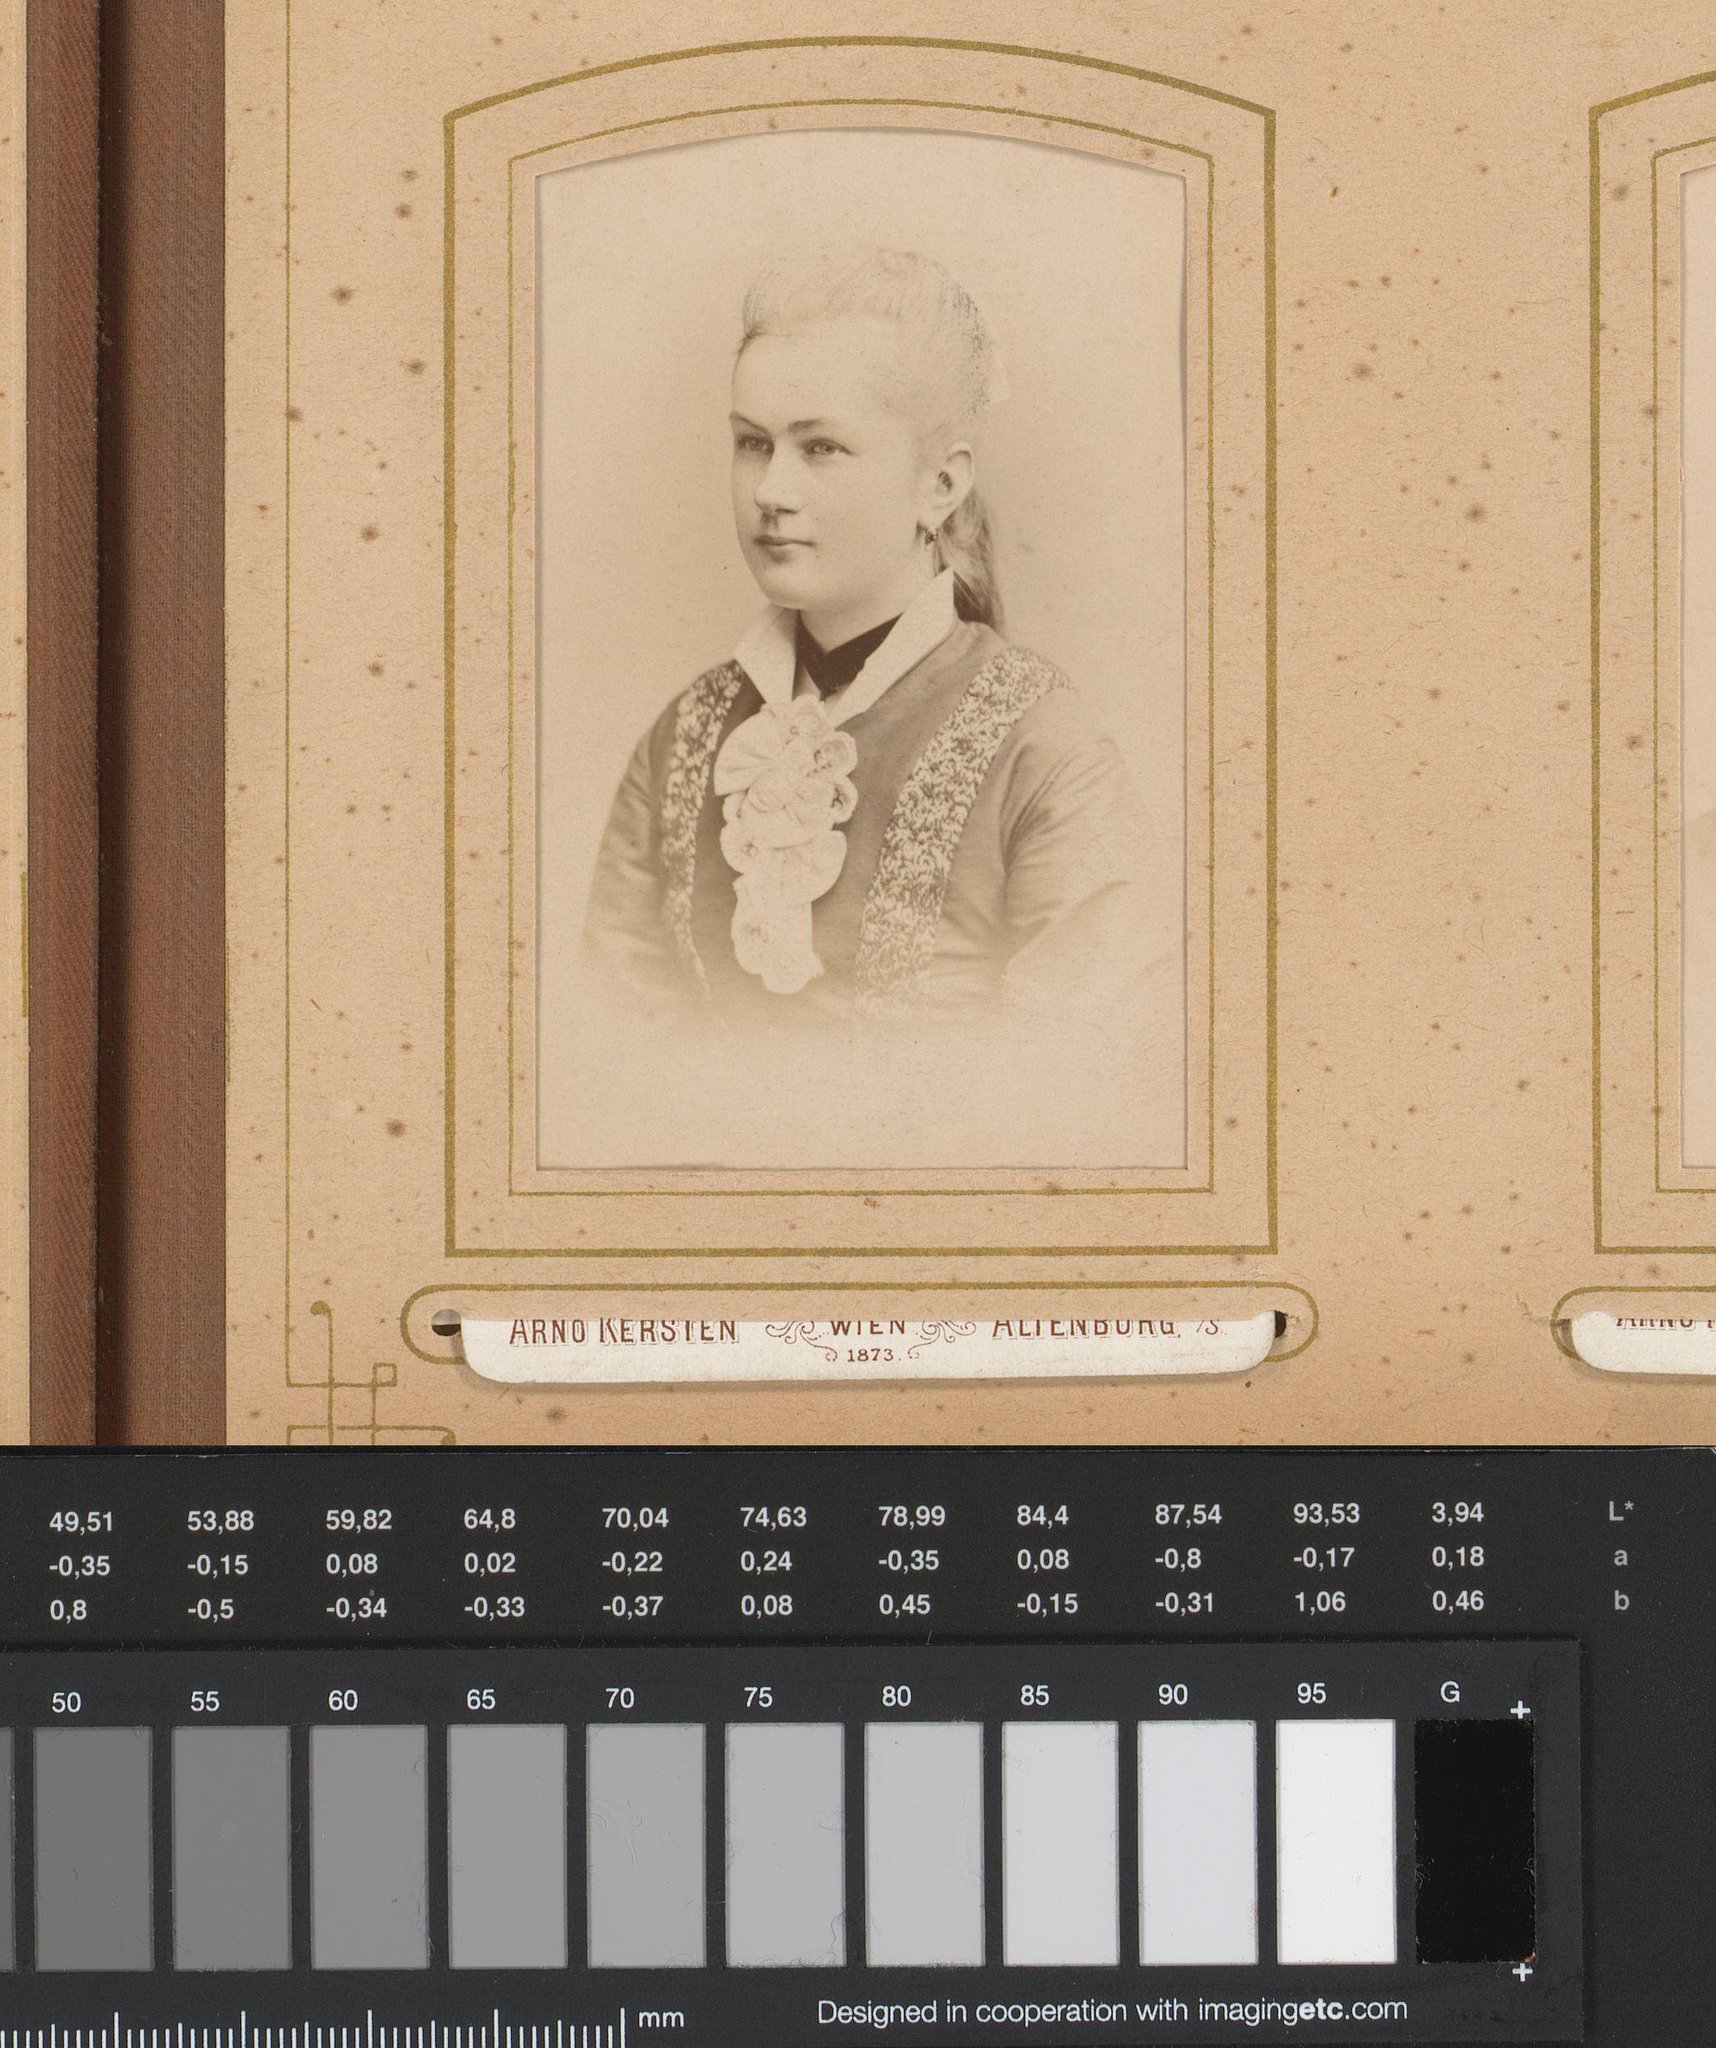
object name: photograph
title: Portret van een jonge vrouw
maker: arno kersten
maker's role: fotograaf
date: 1873-1900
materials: cardboard, photographic support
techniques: albumen print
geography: altenburg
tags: adolescent, young woman, maiden, historical persons - bb - woman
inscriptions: inscription: ‘Arno Kersten/ Hof-Photograph Altenburg i/S./ Albrechtstrasse 9. Ecke der Lindenaustrasse.’